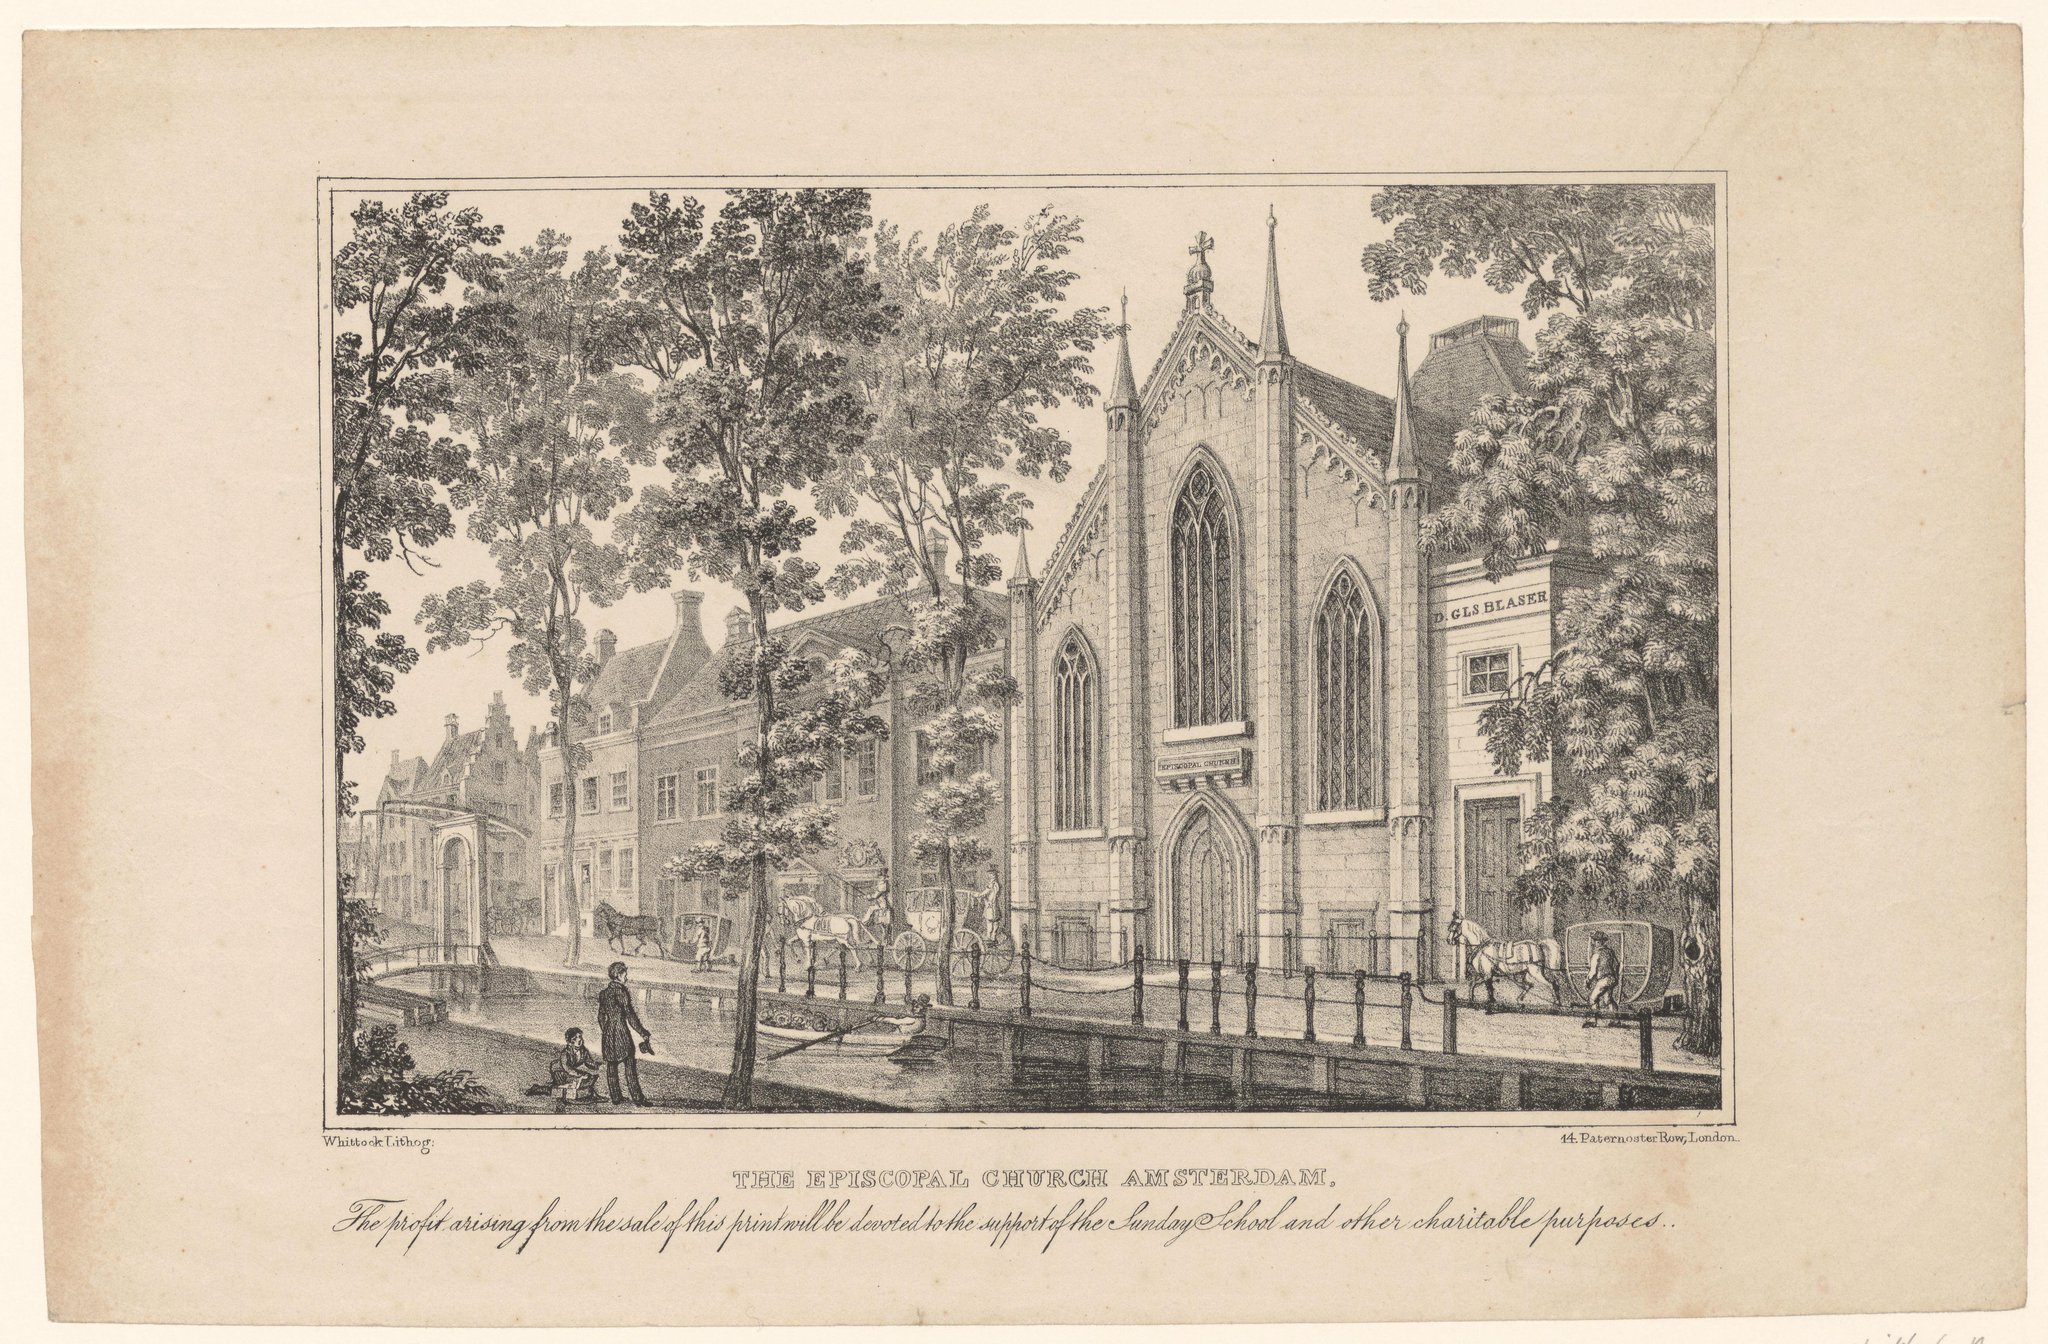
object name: print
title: The Episcopal Church Amsterdam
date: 1825-1830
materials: paper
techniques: lithograph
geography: london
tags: church (exterior), canals, waters (in city), amsterdam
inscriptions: collector's mark: Lugt 2228